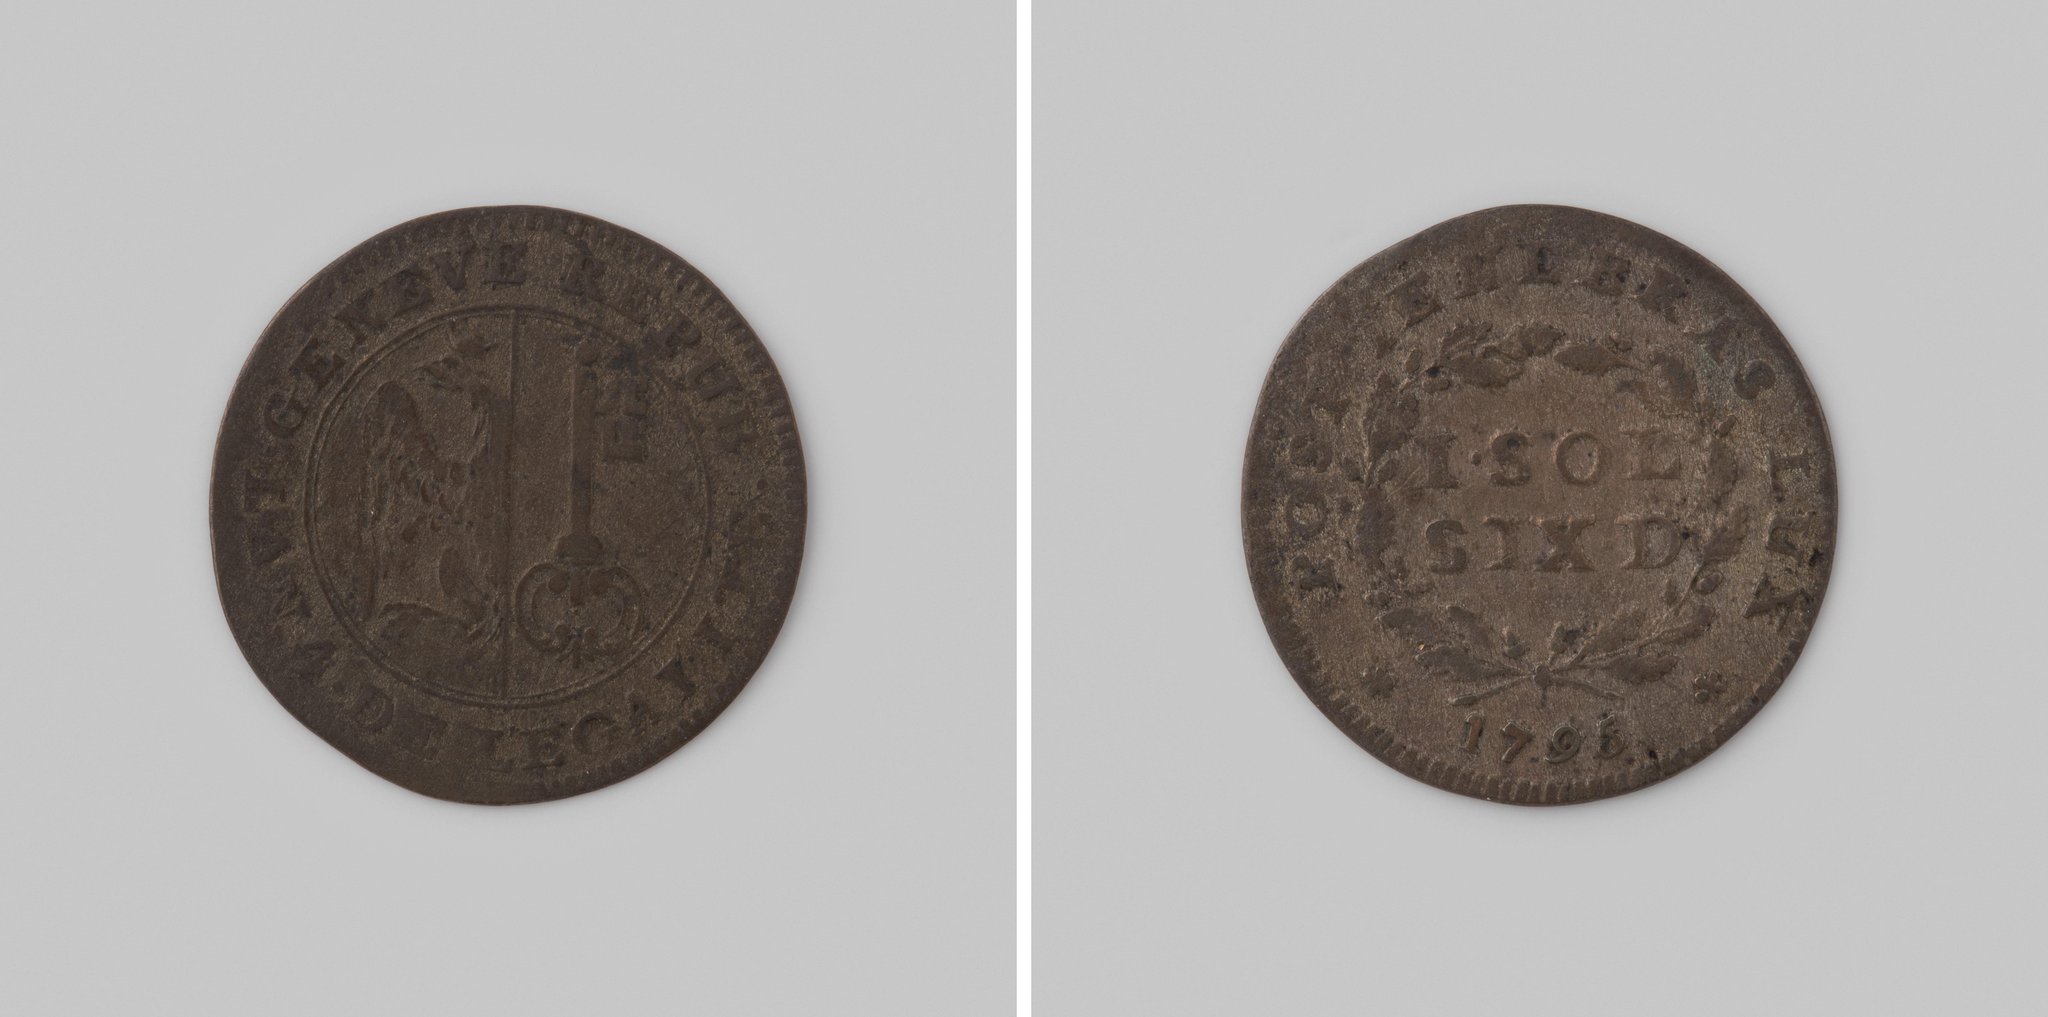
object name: coin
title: 1 sol en 6 deniers uit de stad Geneve, 1795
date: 1795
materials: silver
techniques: striking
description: Koper-zilveren munt. Voorzijde: wapen van Geneve in het veld. Jaartal: an 4 onderaan in omschrift. Keerzijde: binnen twee samengebonden takken in twee regels waarde-aanduiding. Jaartal onderaan in omschrift. Gladde rand.